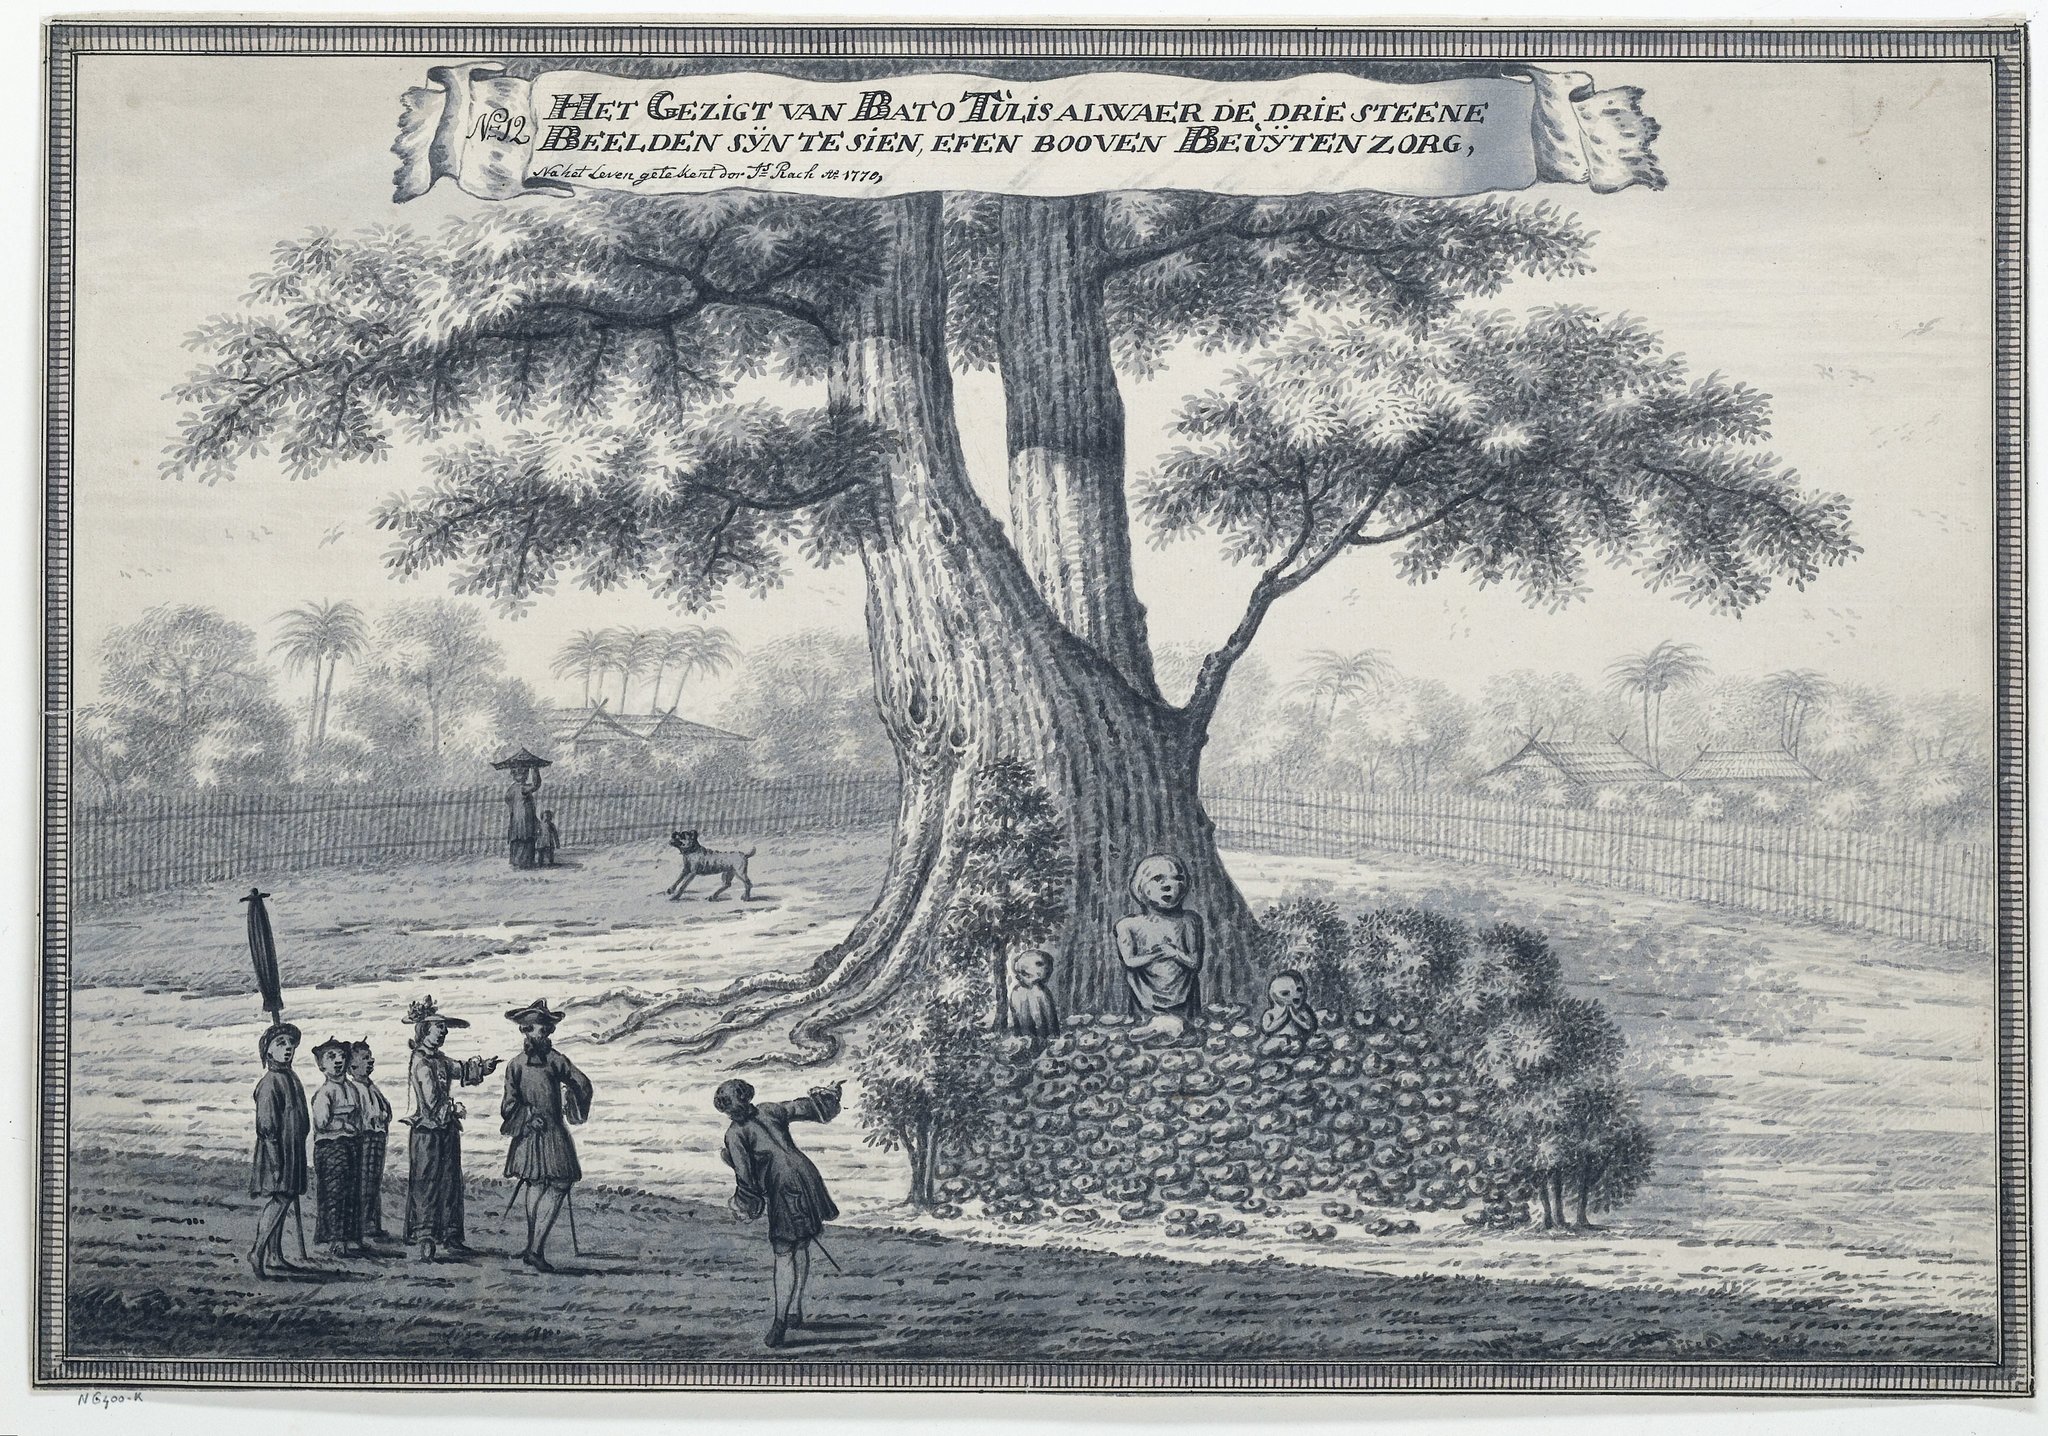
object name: drawing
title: Het Gezigt van Bato Tulis alwaer drie steene syn te sien, effen booven Beuytenzorg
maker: johannes rach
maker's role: draughtsman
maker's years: 1720-1783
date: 1770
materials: ink, paper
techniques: brush, pen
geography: bogor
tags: monument, statue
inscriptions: date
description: Aan de voet van een grote boom staan drie beelden op een voetstuk gebouwd van stenen. De gebied is omheind door een hek waarachter bomen en gebouwen. In de tuin een figuur en een kind onder parasol met een hond en drie Europese bezoekers met drie bedienden. Op een ander deel van het terrein met de Batutulis te Buitenzorg.